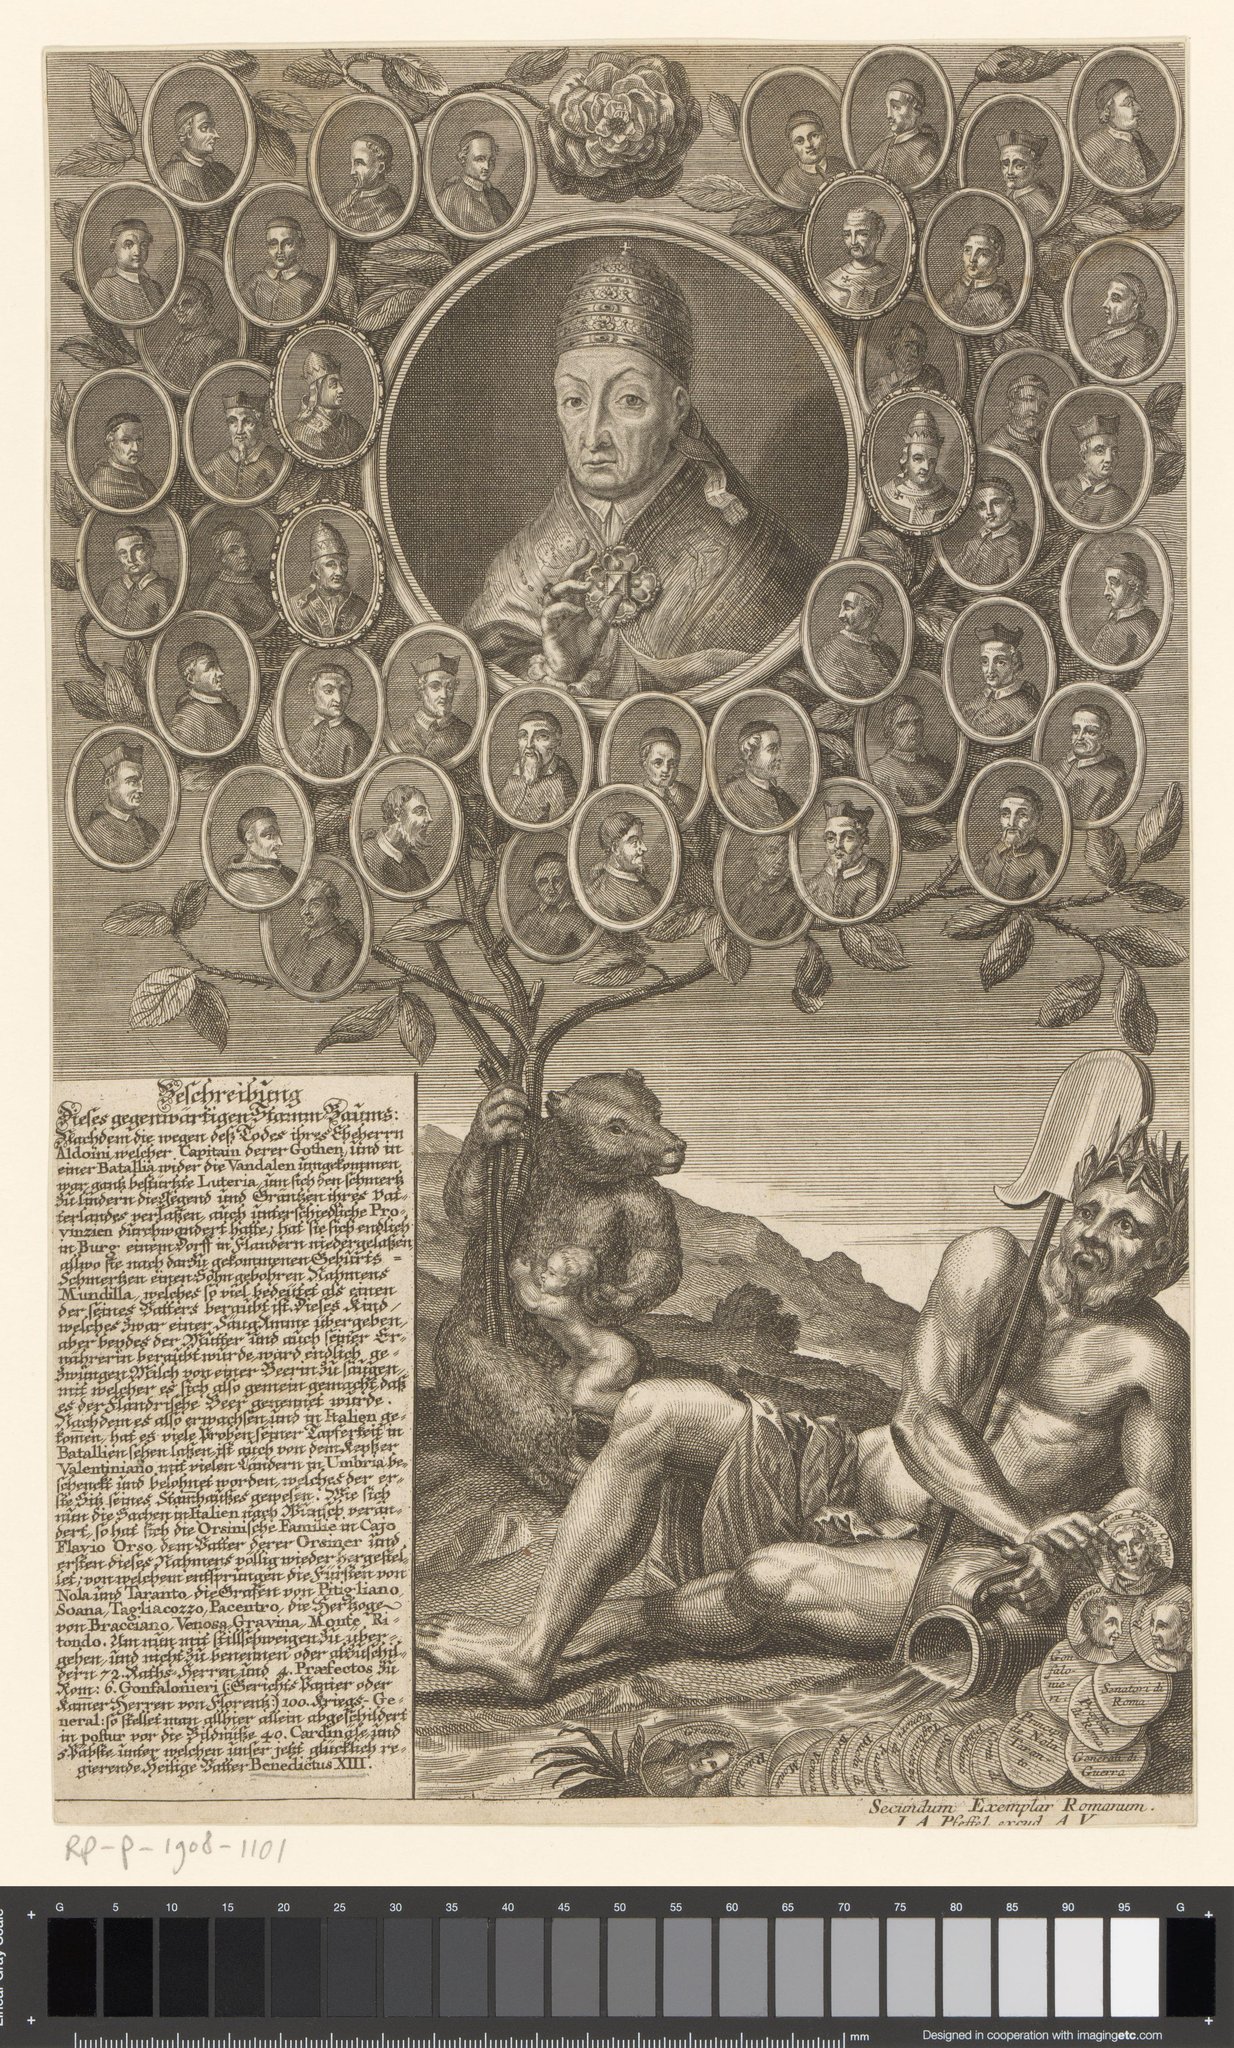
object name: print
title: Stamboom met portret van Benedictus XIII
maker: johann andreas pfeffel (der ältere)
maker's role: print maker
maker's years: 1674-1748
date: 1724-1748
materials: paper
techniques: engraving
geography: augsburg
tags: benedictus xiii, river personified, 'fiumi' (ripa), child suckled by animal, historical persons, family lineage, pedigree, genealogical tree or table, beasts of prey, predatory animals: bear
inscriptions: collector's mark: Lugt 2233